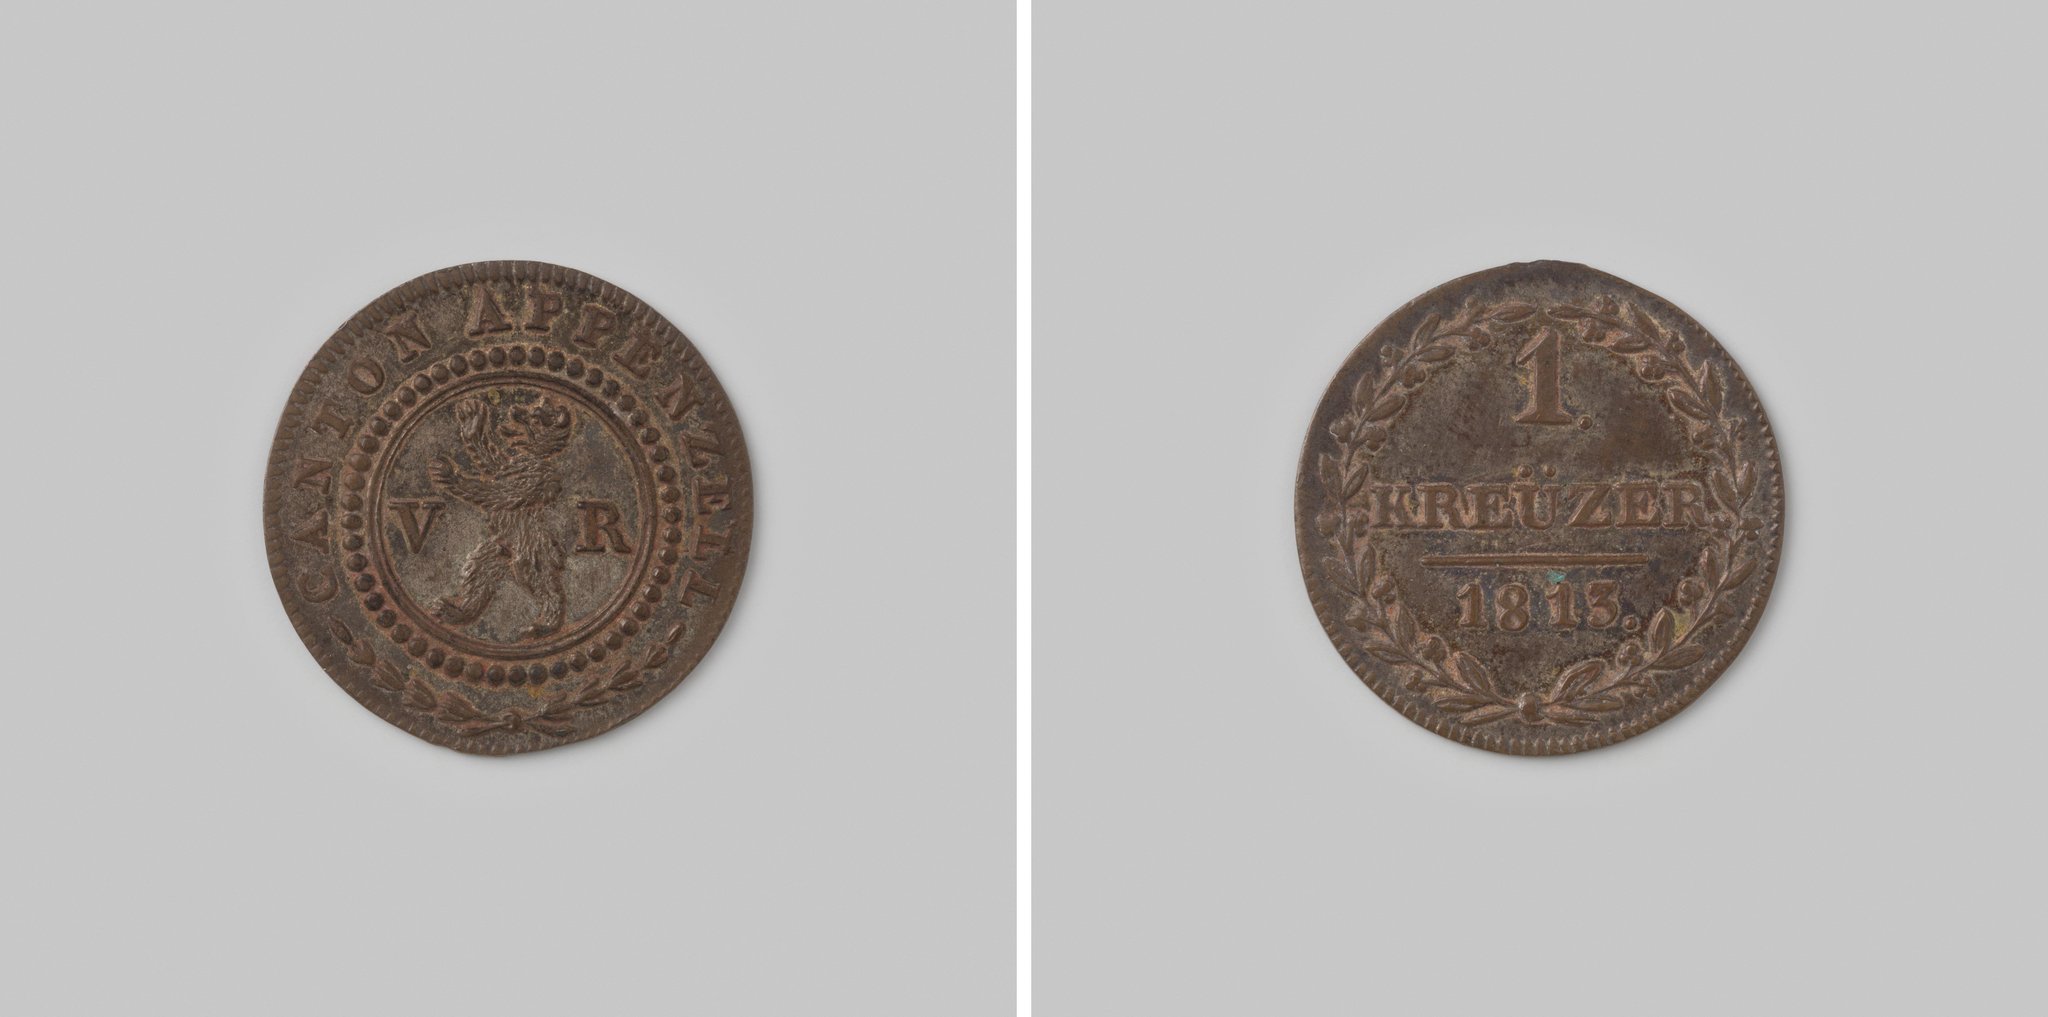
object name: coin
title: Kanton Appenzell, kreuzer, 1813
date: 1813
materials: copper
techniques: striking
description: Koperen munt. Voorzijde: binnen parelcirkel, waaronder versiering, rond wapenschild. Keerzijde: binnen twee samengebonden takken in twee regels waarde-aanduiding, waaronder jaartal. Gladde rand.